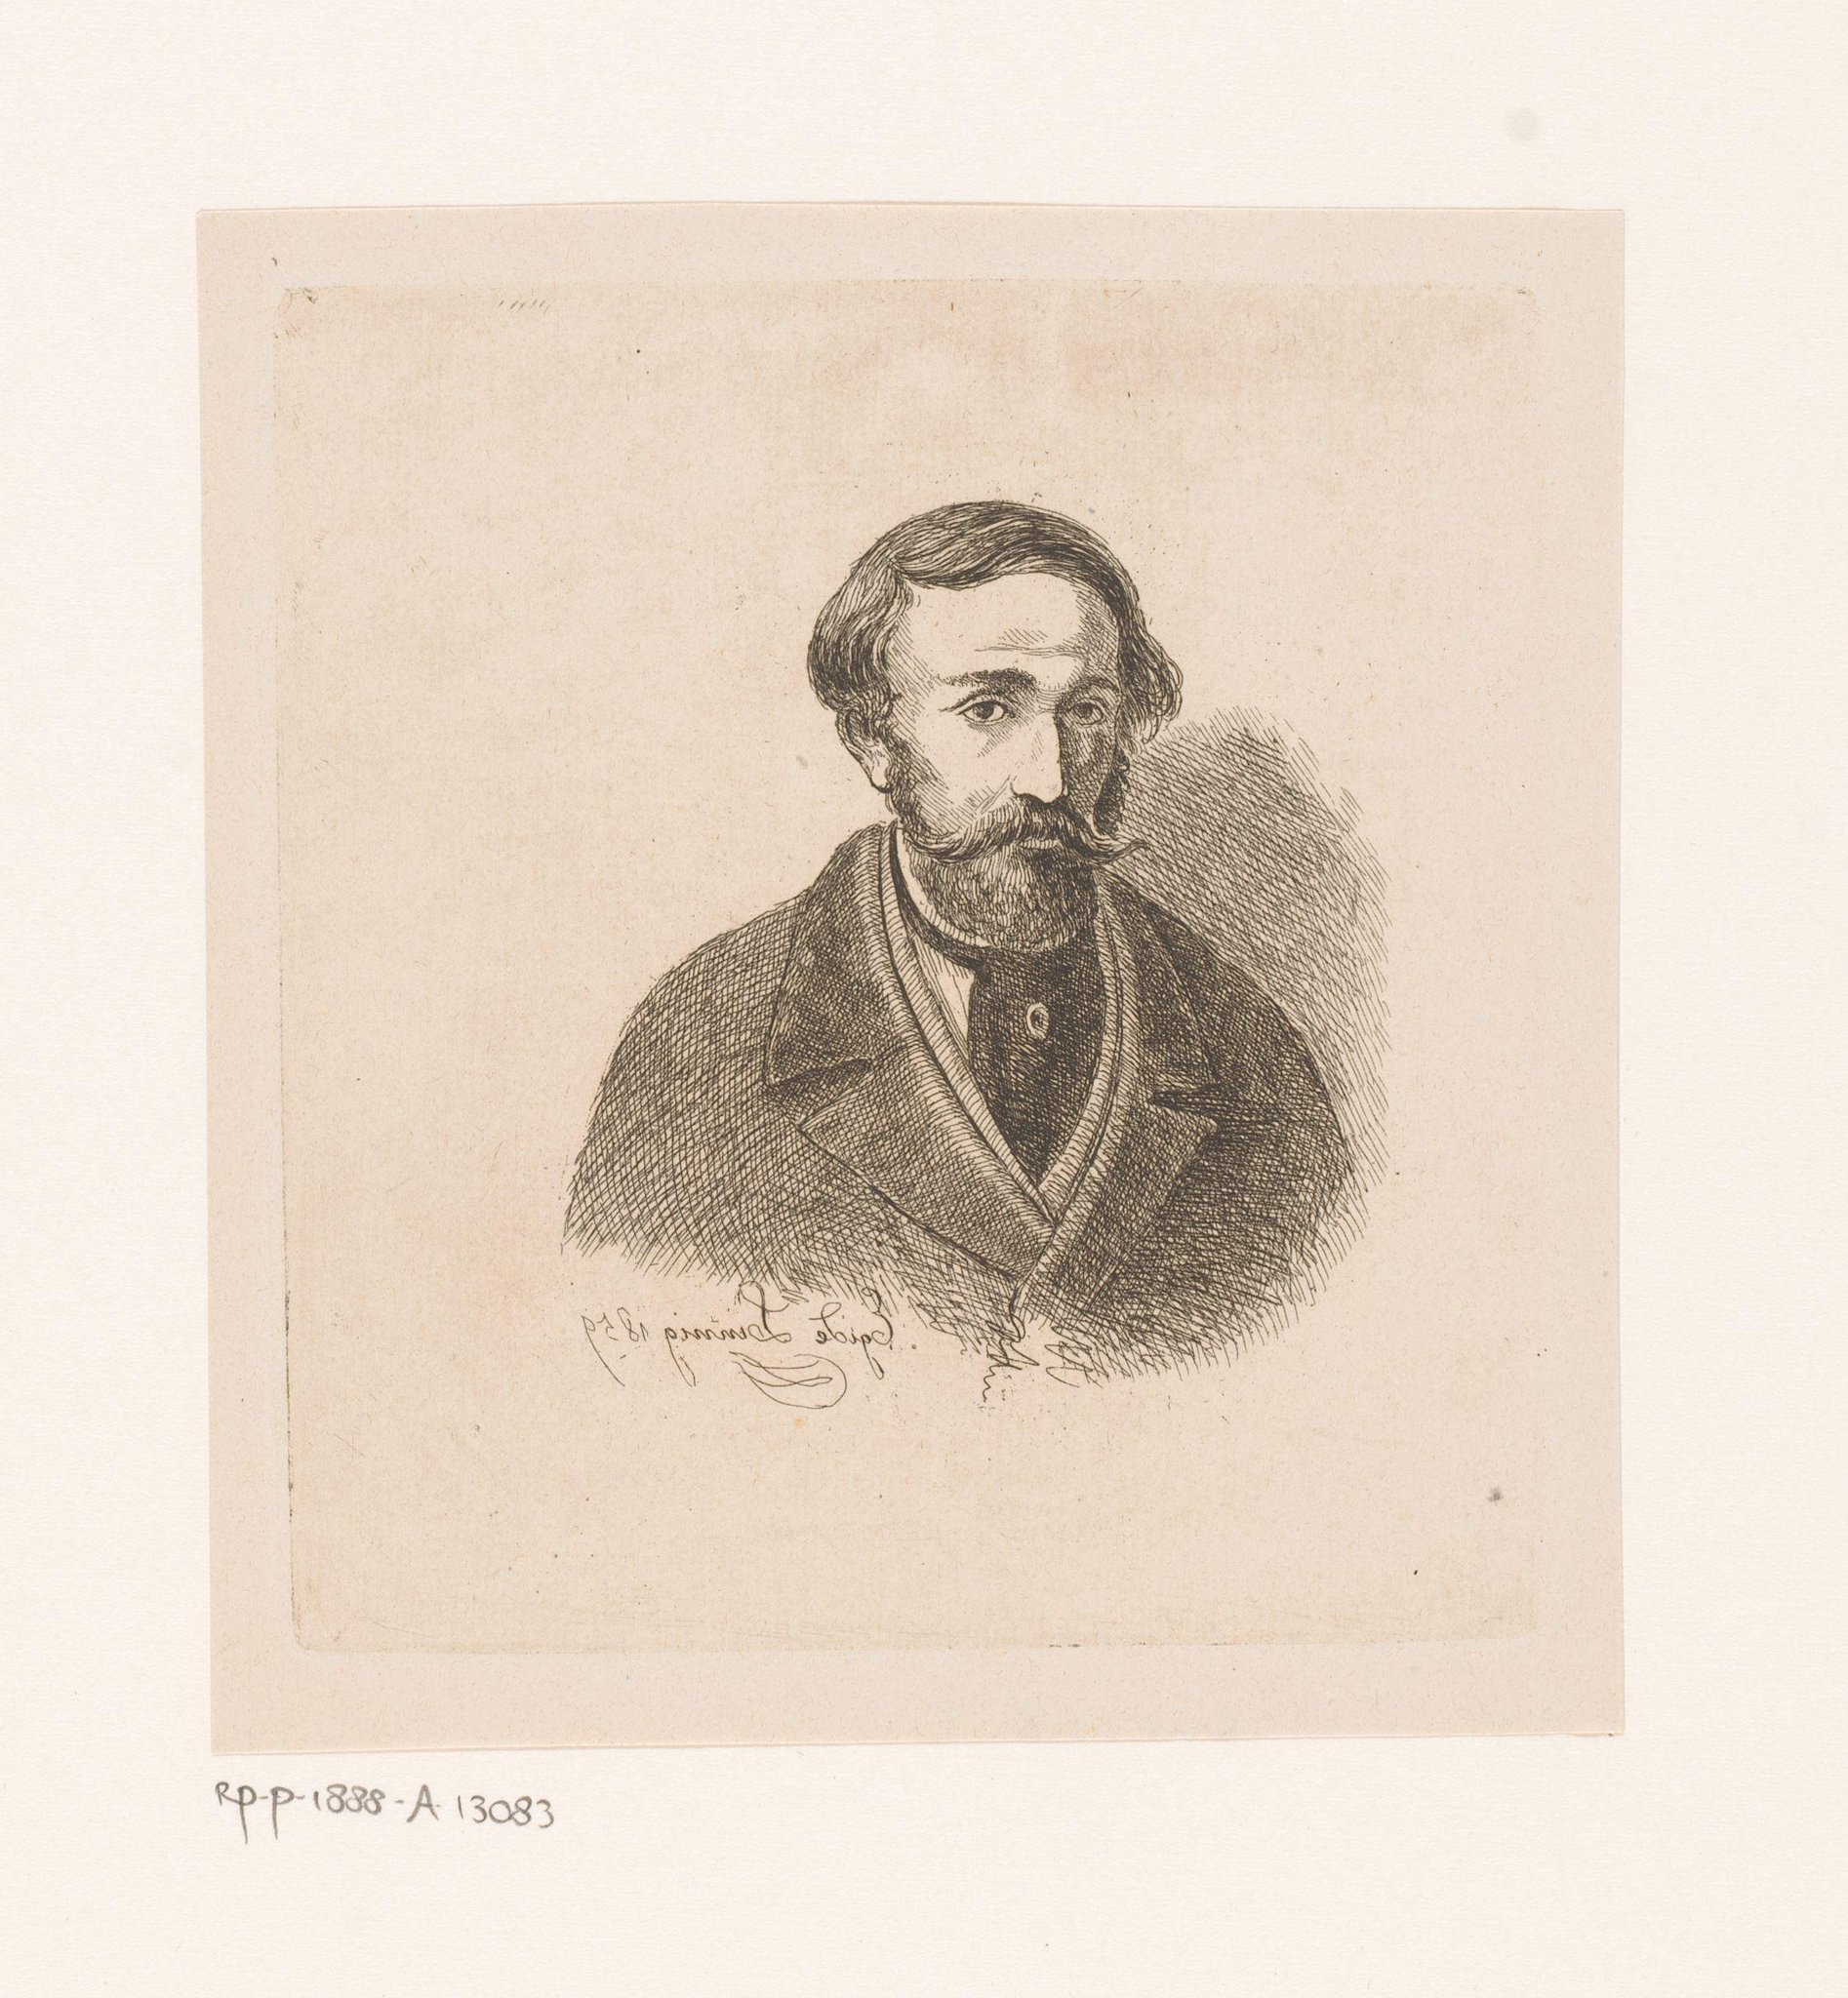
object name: print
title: Zelfportret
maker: egidius linnig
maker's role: draughtsman, print maker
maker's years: 1821-1860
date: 1859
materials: paper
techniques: etching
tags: antwerp, print maker, draughtsman, egidius linnig, portrait, self-portrait of artist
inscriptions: collector's mark: Lugt 2228